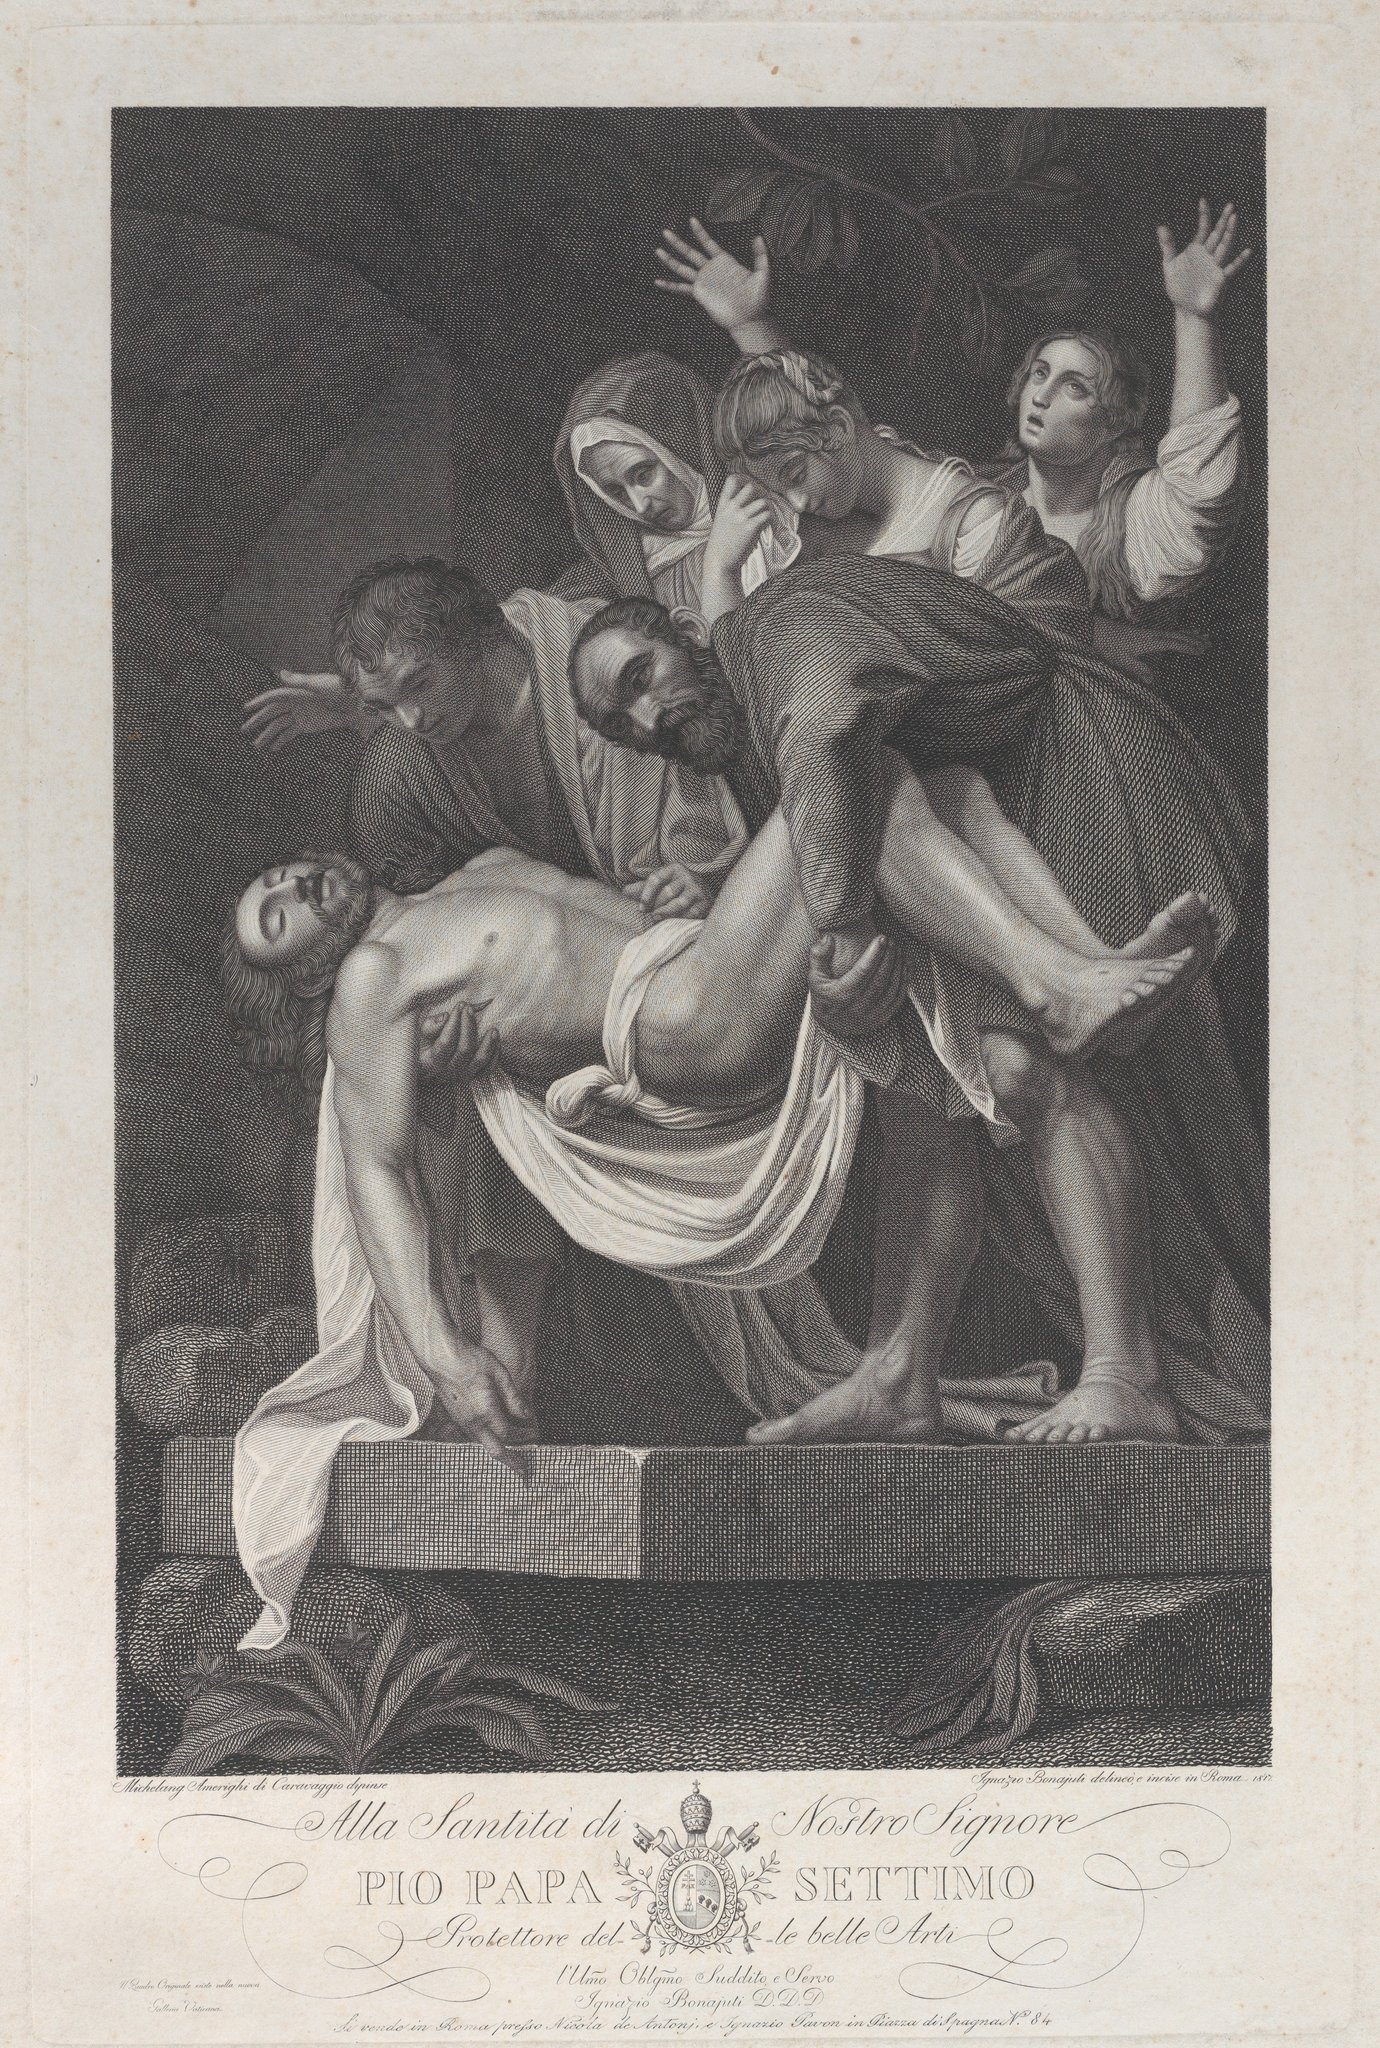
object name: print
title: The Entombment of Christ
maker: ignazio bonajuti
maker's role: artist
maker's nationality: italian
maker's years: 1750-1850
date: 1817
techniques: engraving